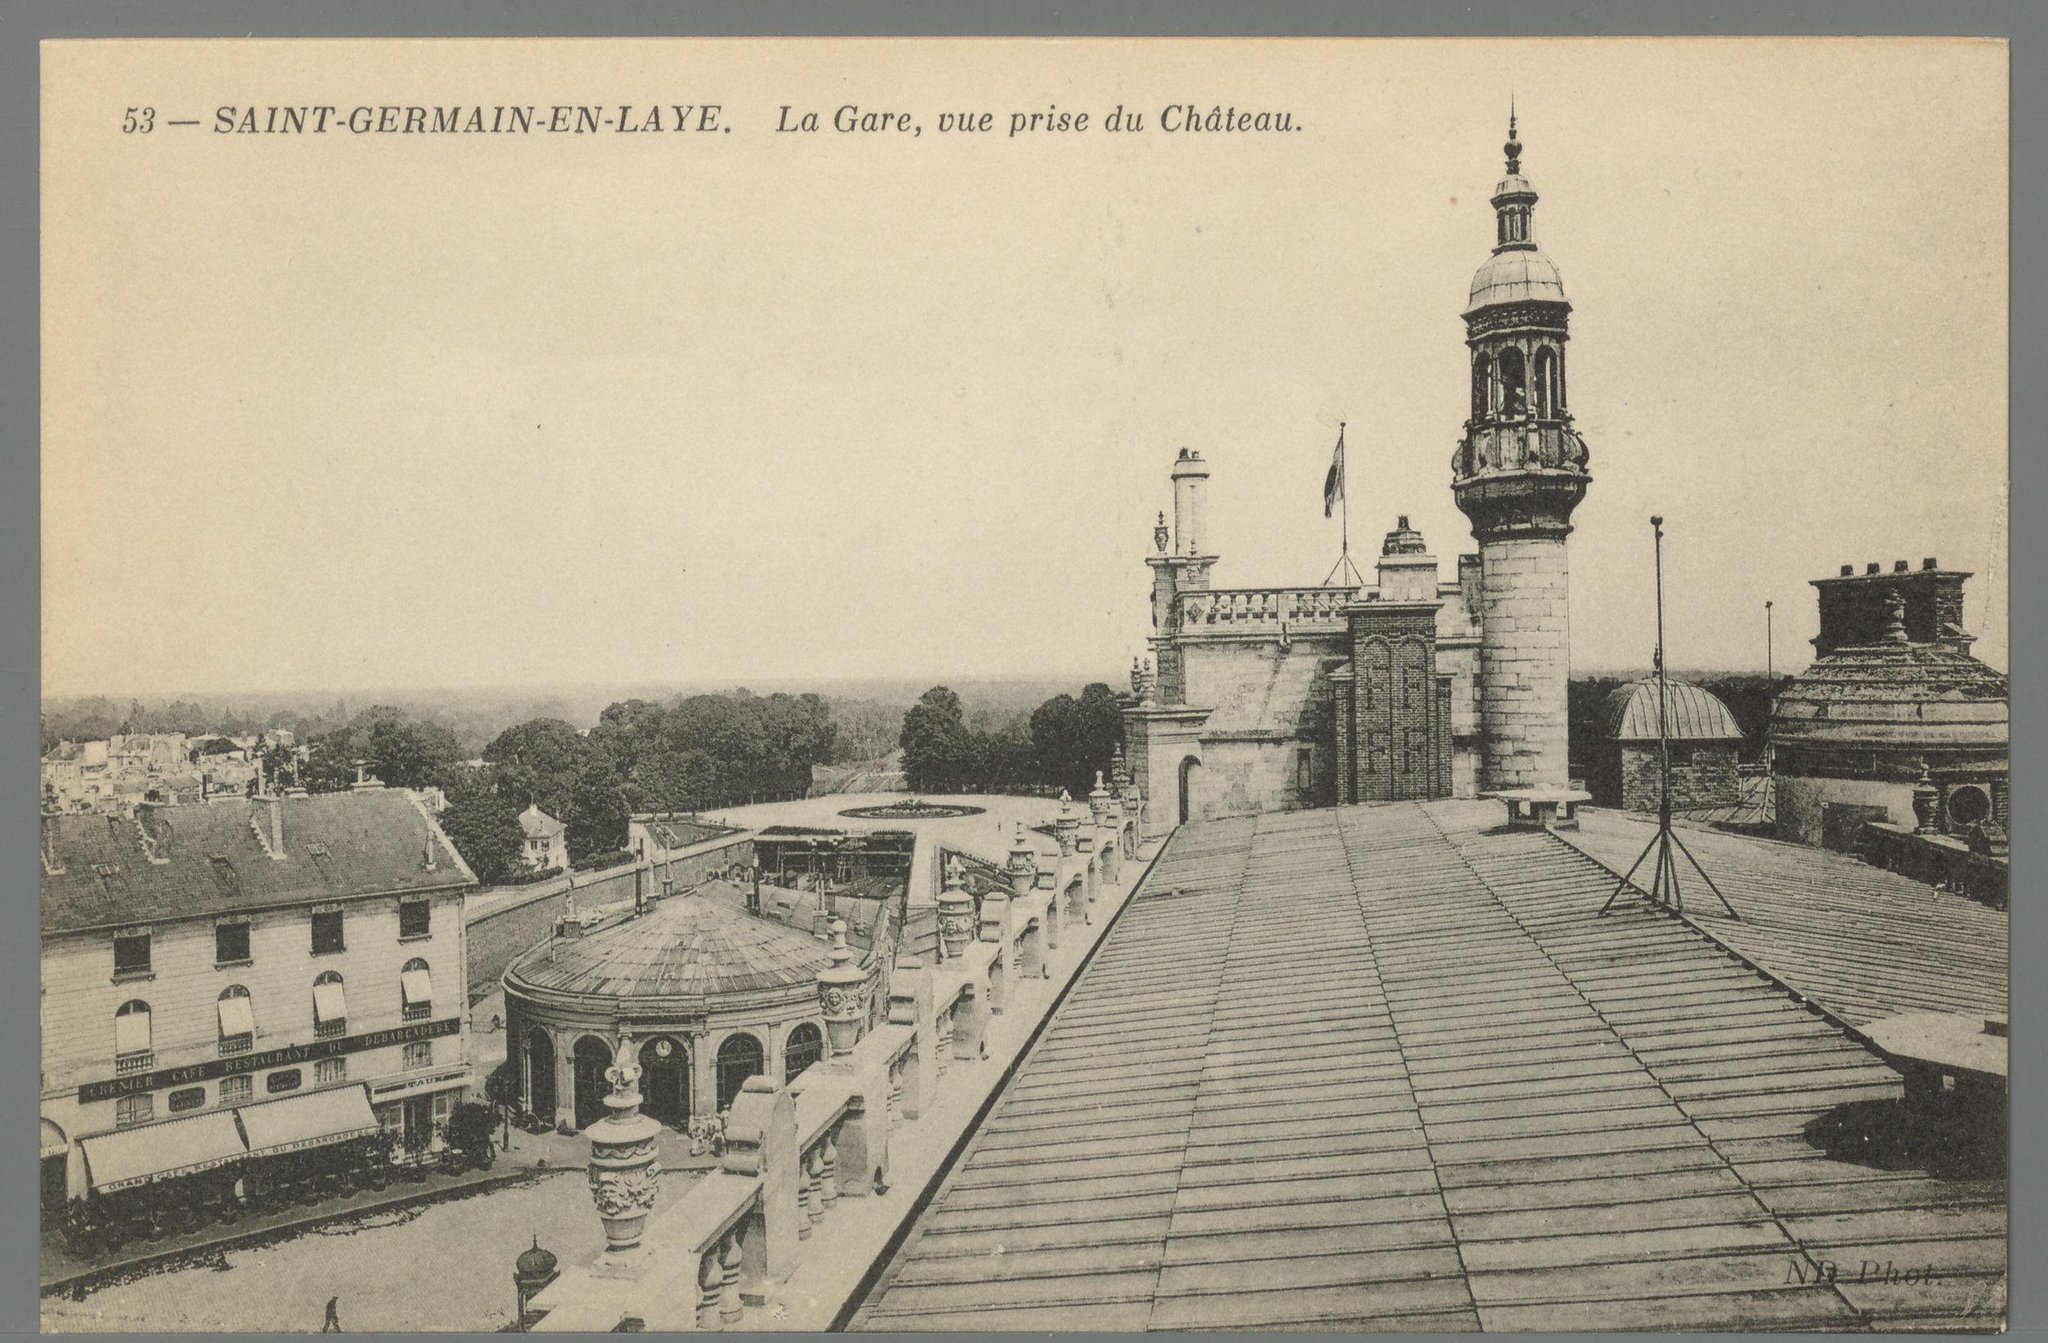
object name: photomechanical print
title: Saint-Germain-en-Laye. La Gare, vue prise du Château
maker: Anonymous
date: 1903-1918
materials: cardboard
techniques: photograph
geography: saint-germain-en-laye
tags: city-view, and landscape with man-made constructions, station; shelter (railway, tramway)